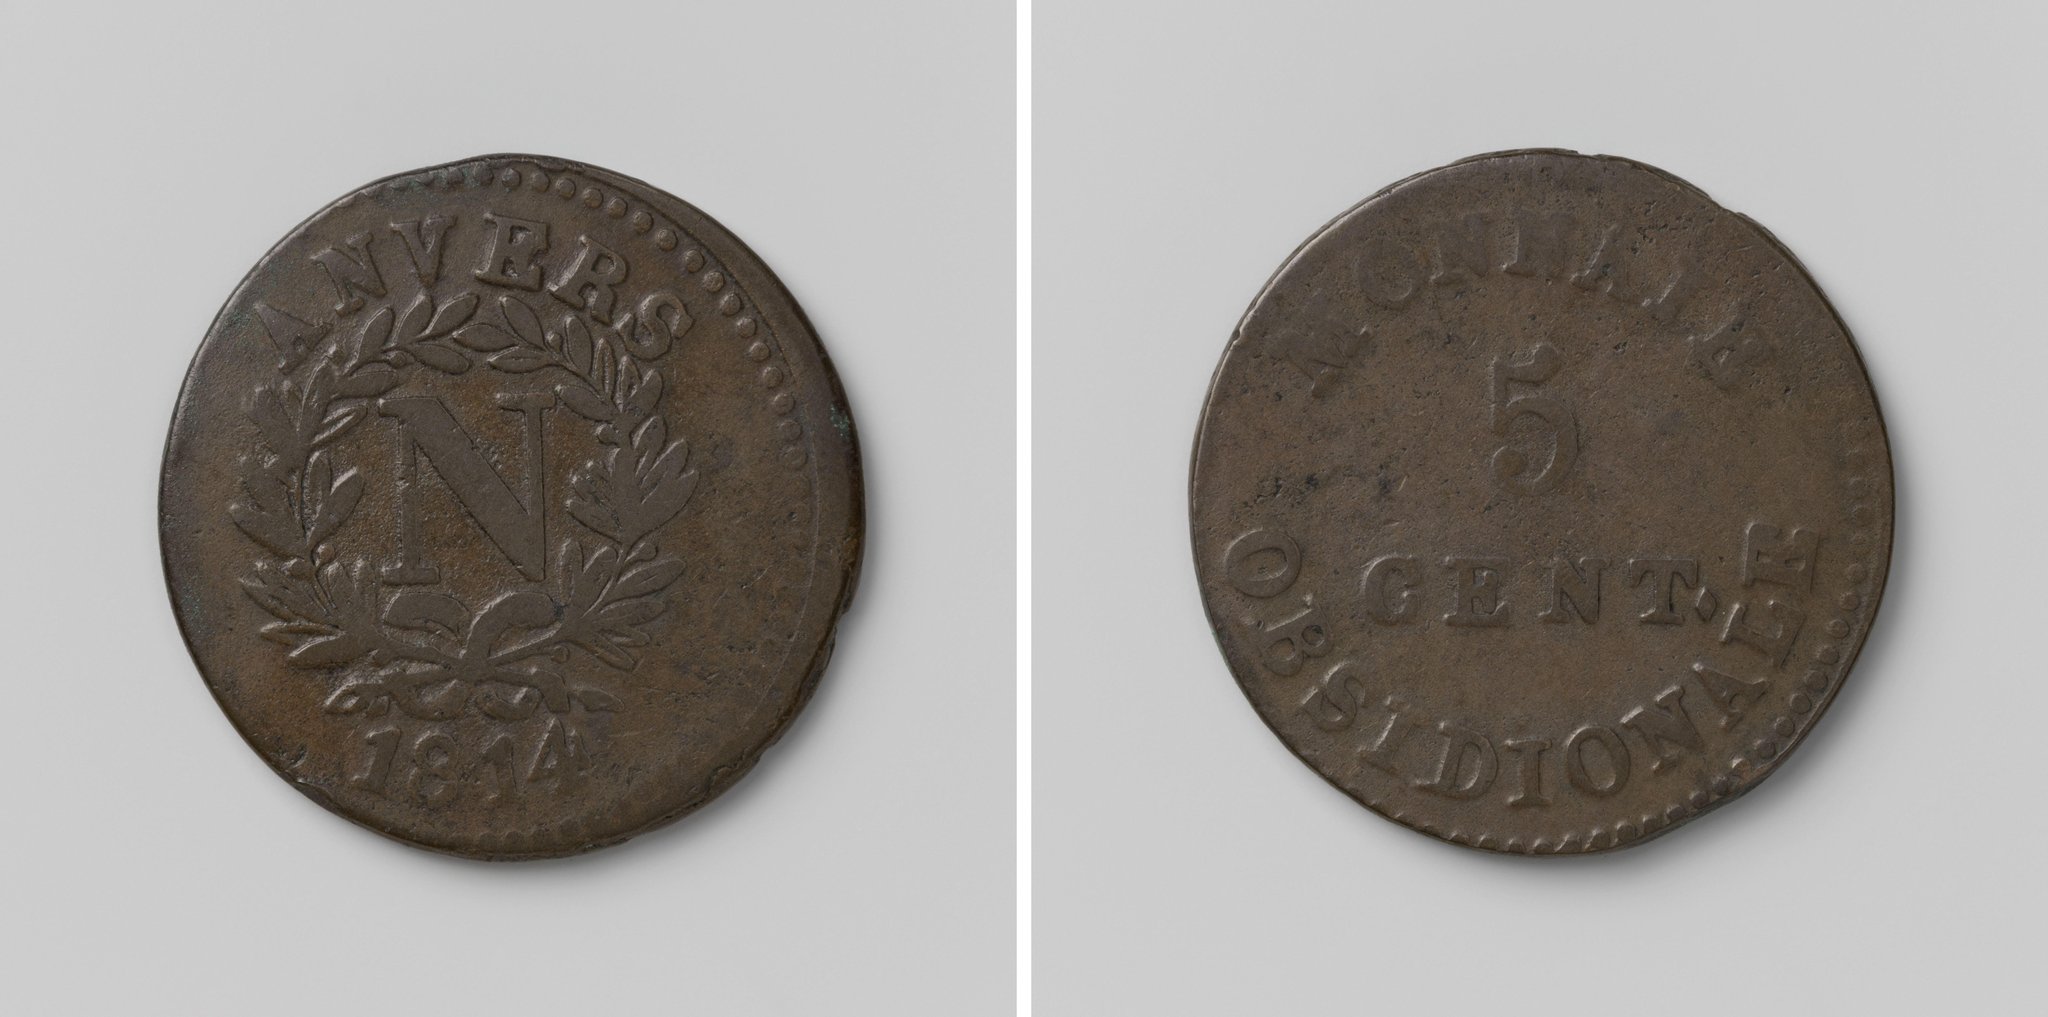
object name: vijf cent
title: Beleg van Antwerpen, noodmunt van vijf cent geslagen door Napoleon I Bonaparte, keizer der Fransen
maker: Anonymous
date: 1814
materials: copper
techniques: striking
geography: antwerp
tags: napoleon i (emperor of the french), antwerp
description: Koperen noodmunt. Voorzijde:letter N binnen lauwerkrans onder opschrift boven jaartal. Keerzijde: waardeaanduiding binnen omschrift.